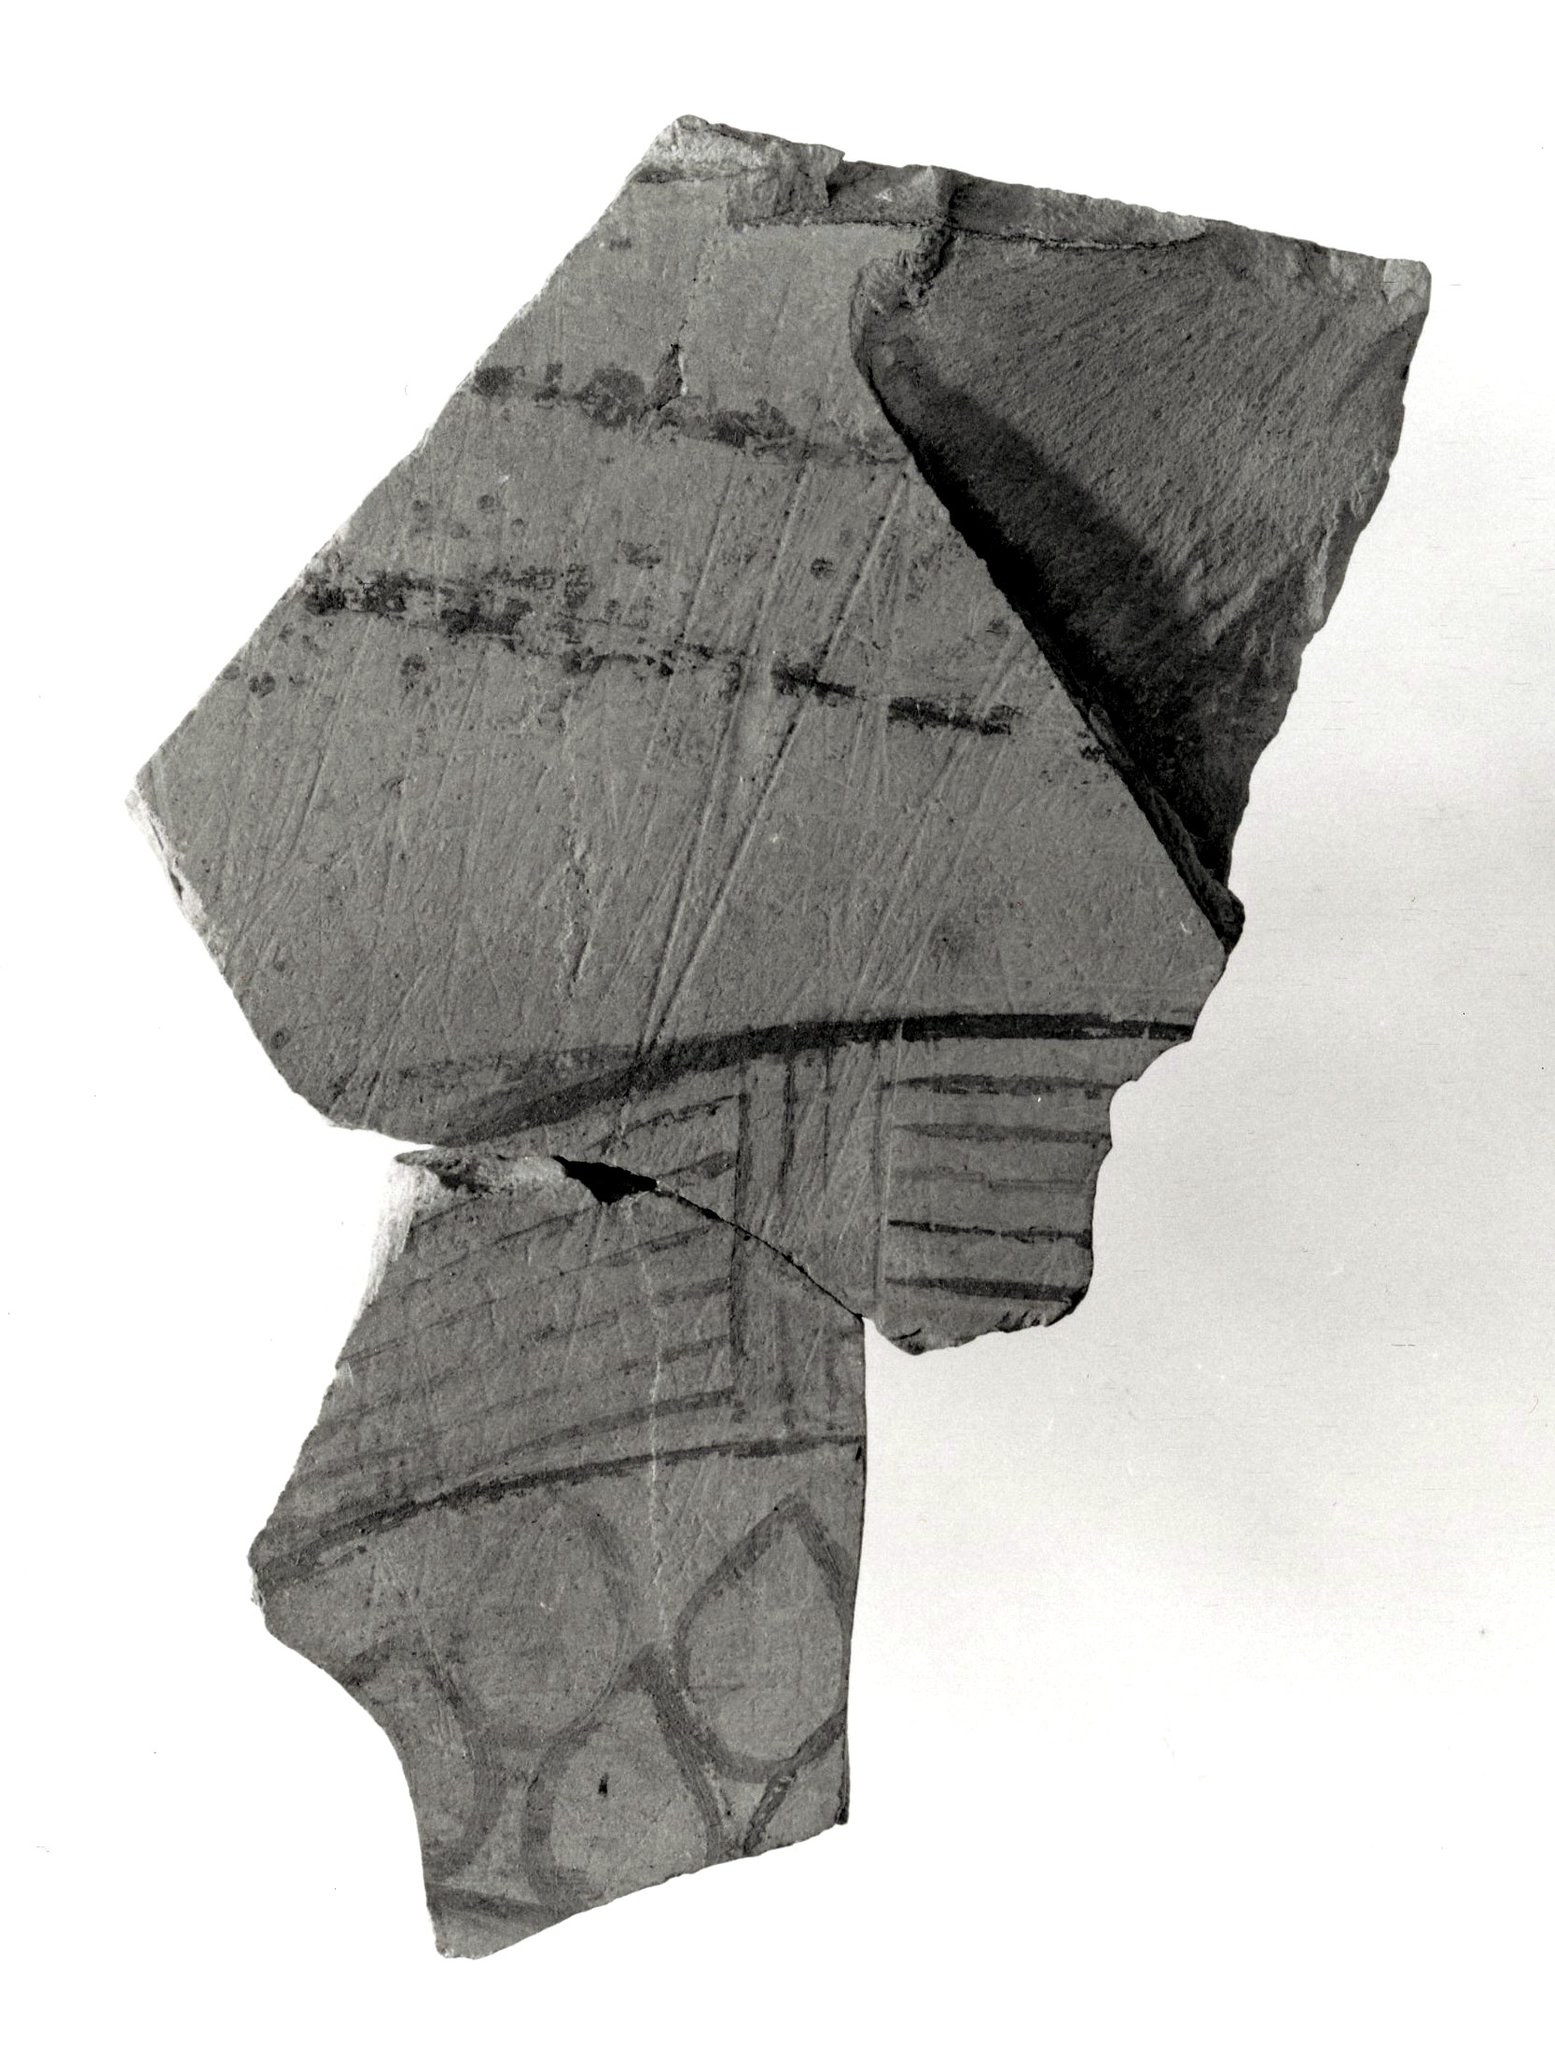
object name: relief, tomb of nespekashuty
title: Drawing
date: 664-610 BCE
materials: limestone, varnish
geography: egypt